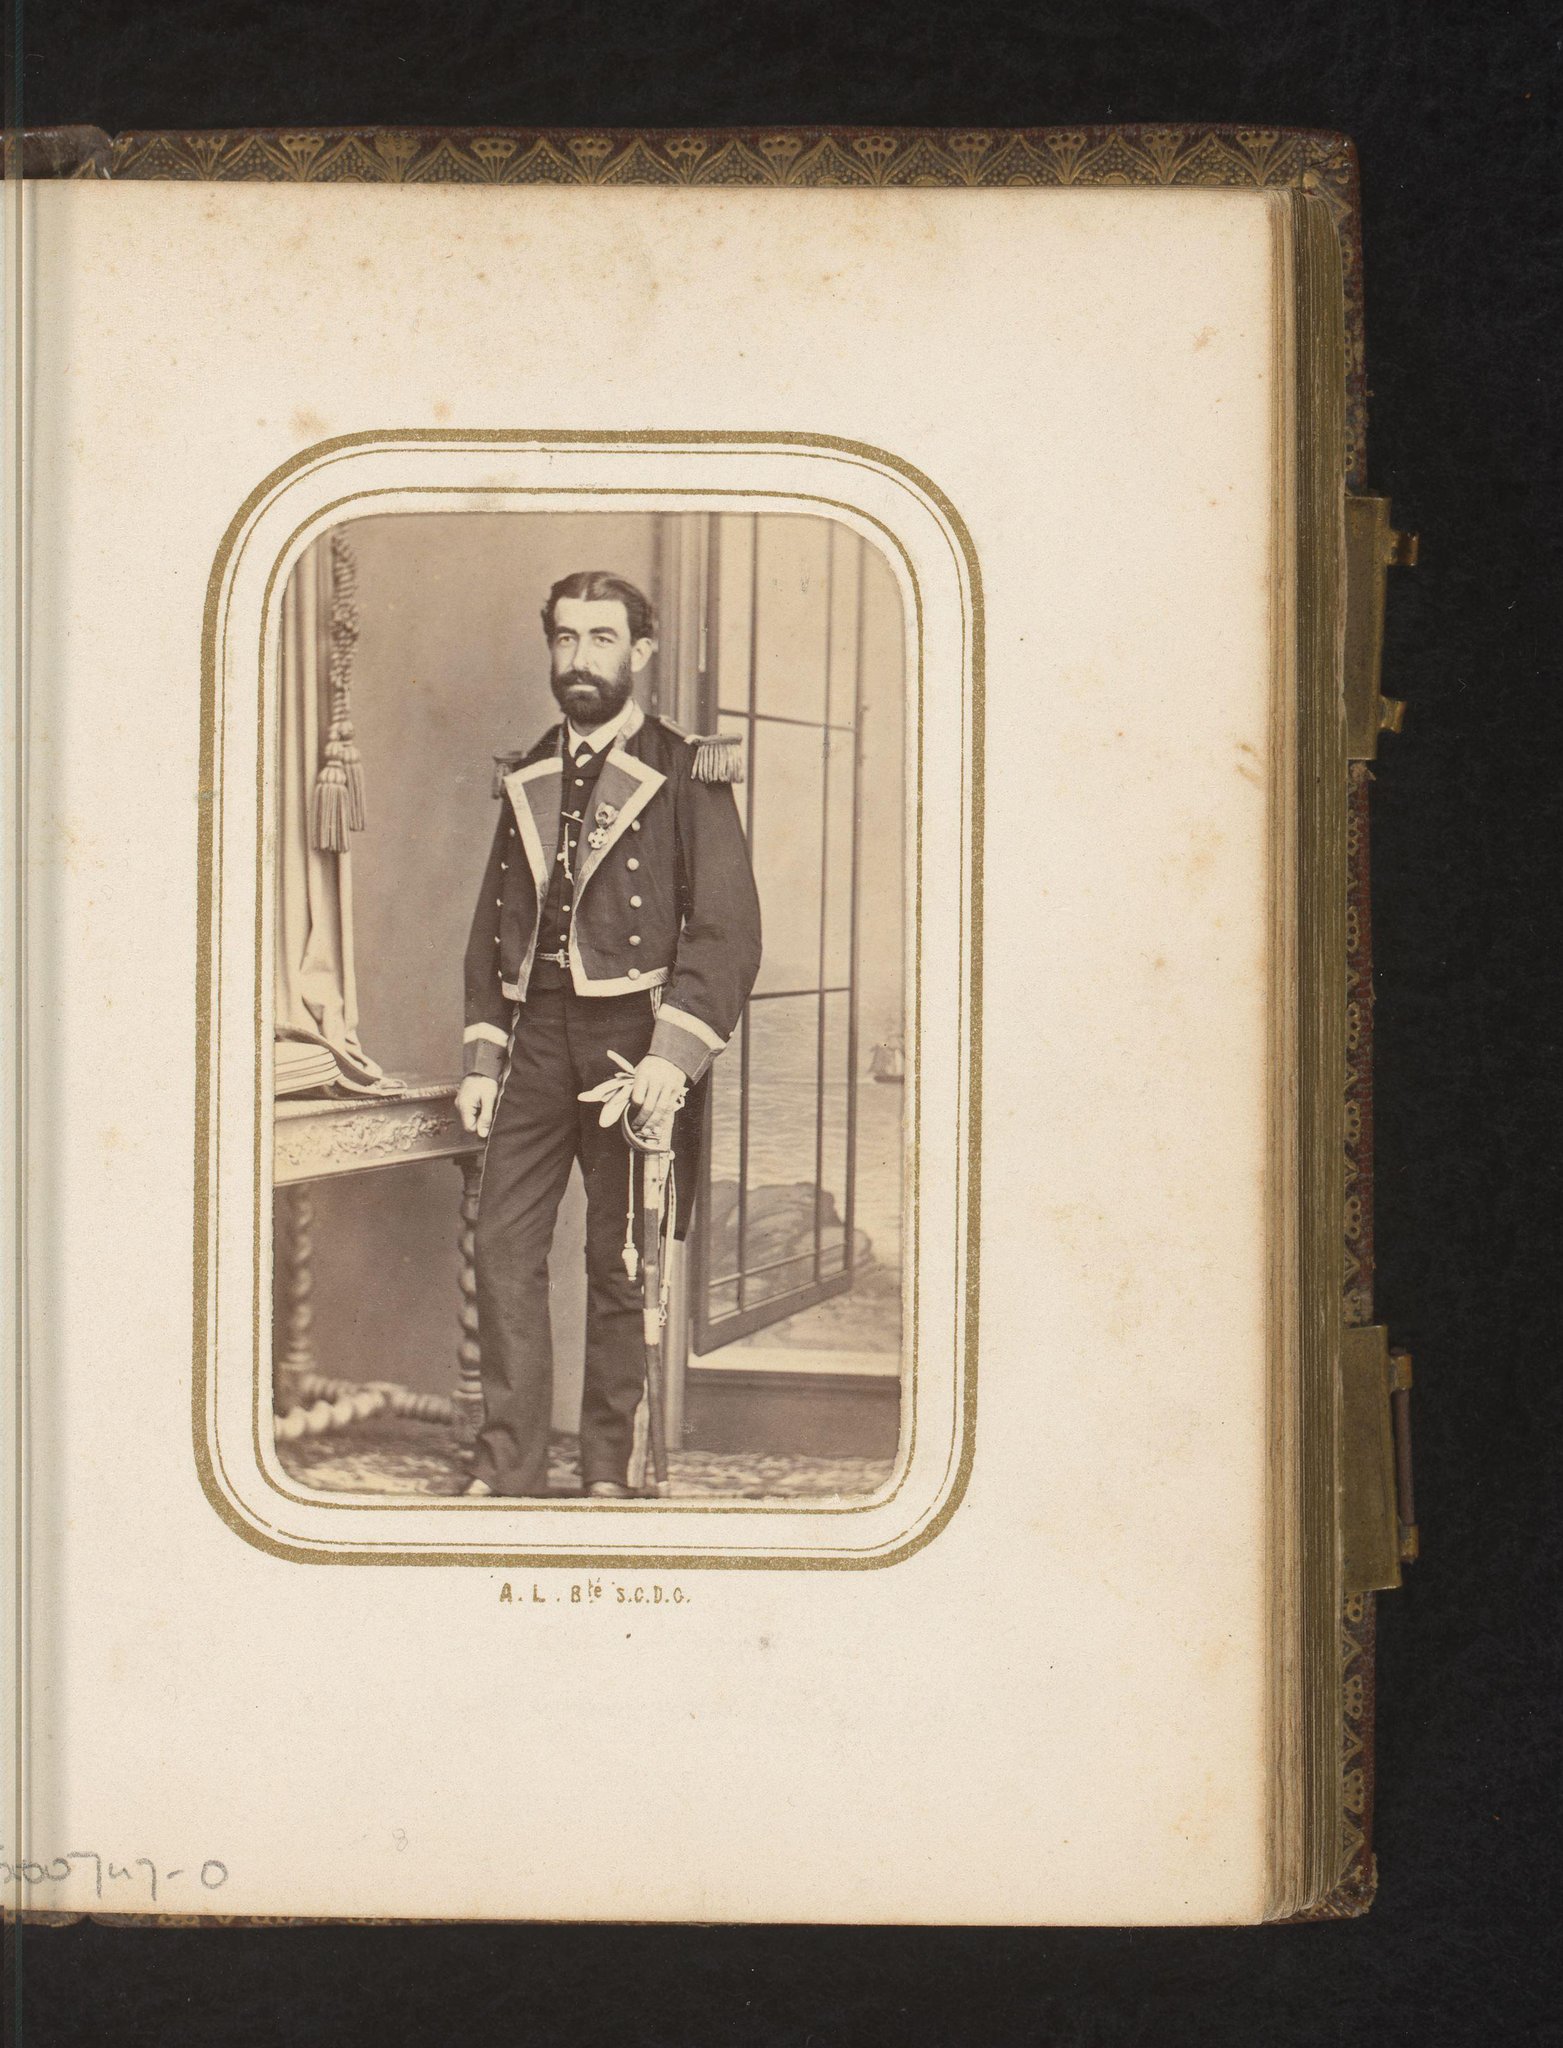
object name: album leaf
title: Portret van een staande man in uniform met sabel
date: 1855-1890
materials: cardboard, photographic support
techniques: albumen print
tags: adult man, historical persons, (military) uniforms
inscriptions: inscription: ‘Linares è hijo/ photografos/ Calle de Sn Francisco No 7/ Cartagena’, inscription: ‘A.L. B.te S.C.D.G.’